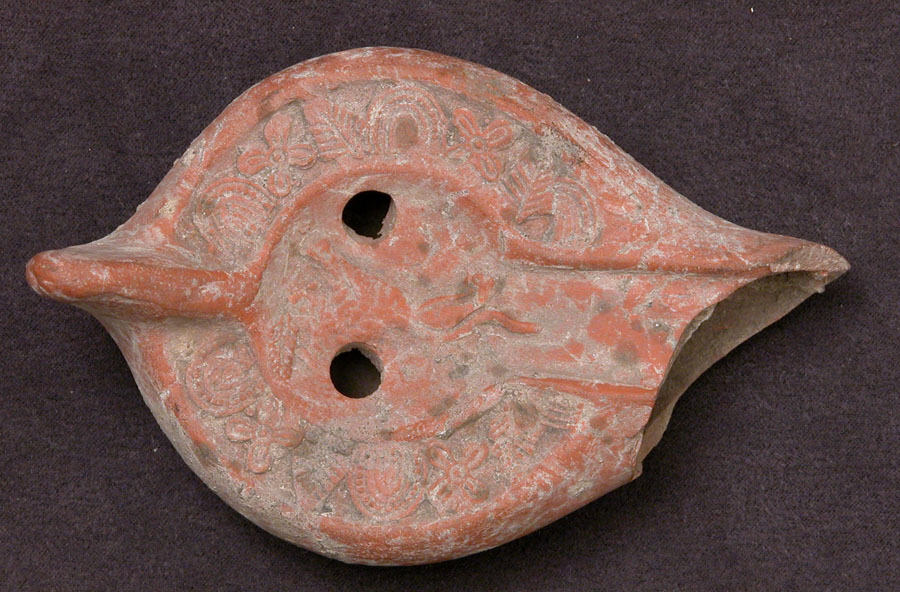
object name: lamp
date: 401-600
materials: earthenware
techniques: molding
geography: egypt